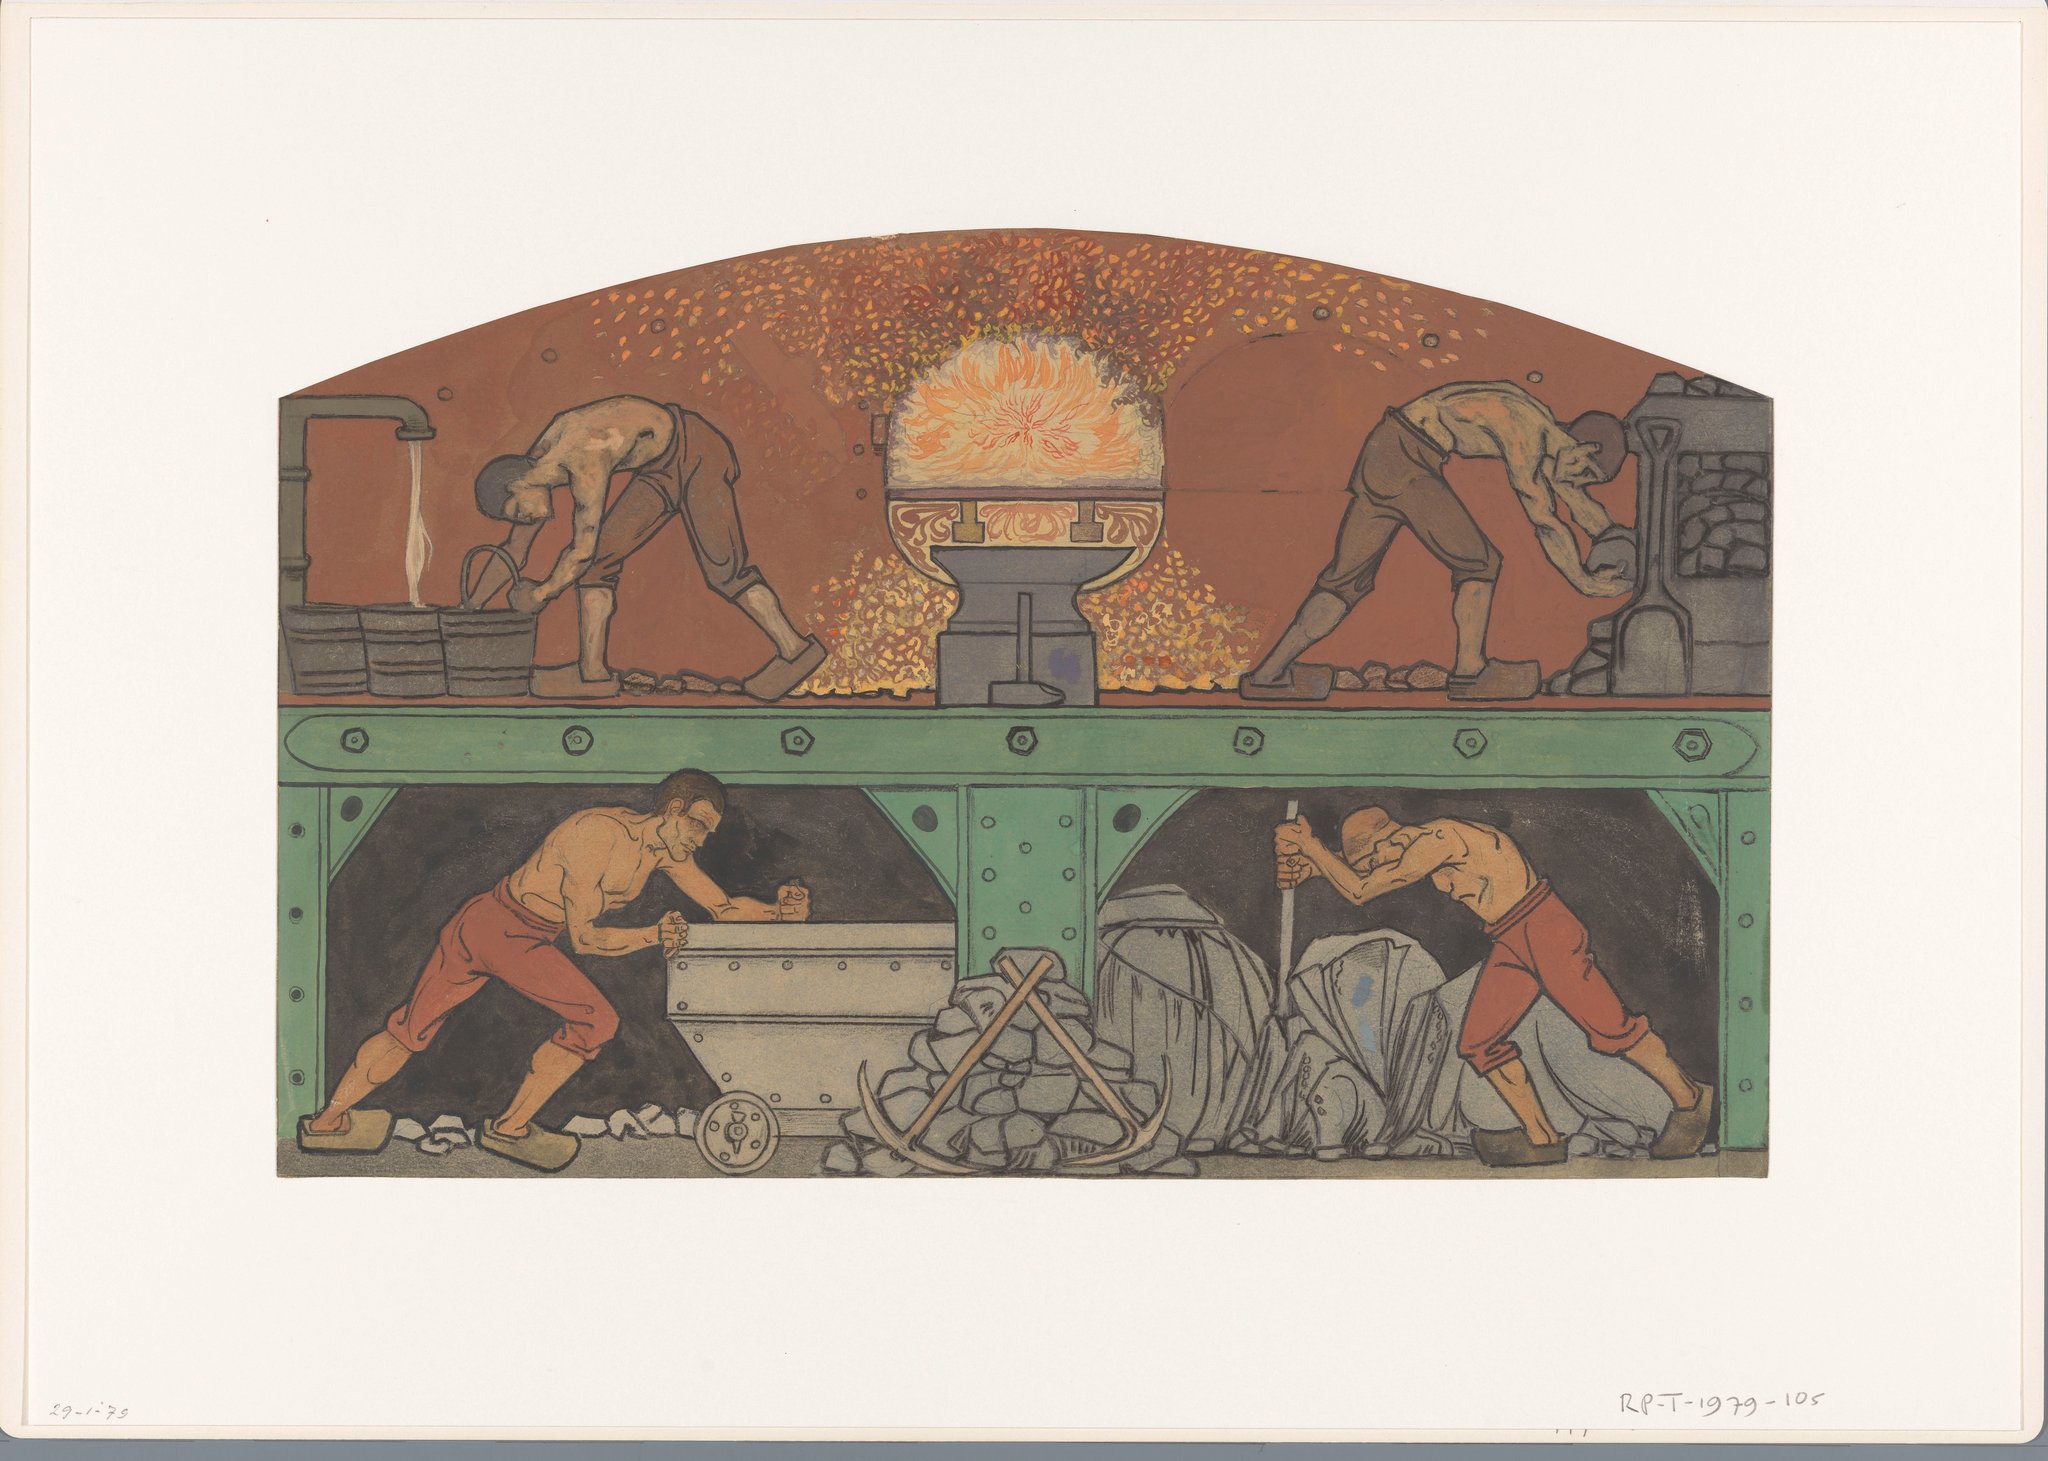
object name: drawing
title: Ontwerp voor schildering in de beurs van Berlage: De Industrie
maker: richard nicolaüs roland holst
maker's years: 1868-1938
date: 1878-1938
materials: paper, pencil, watercolor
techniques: brush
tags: mining, iron and steel industry